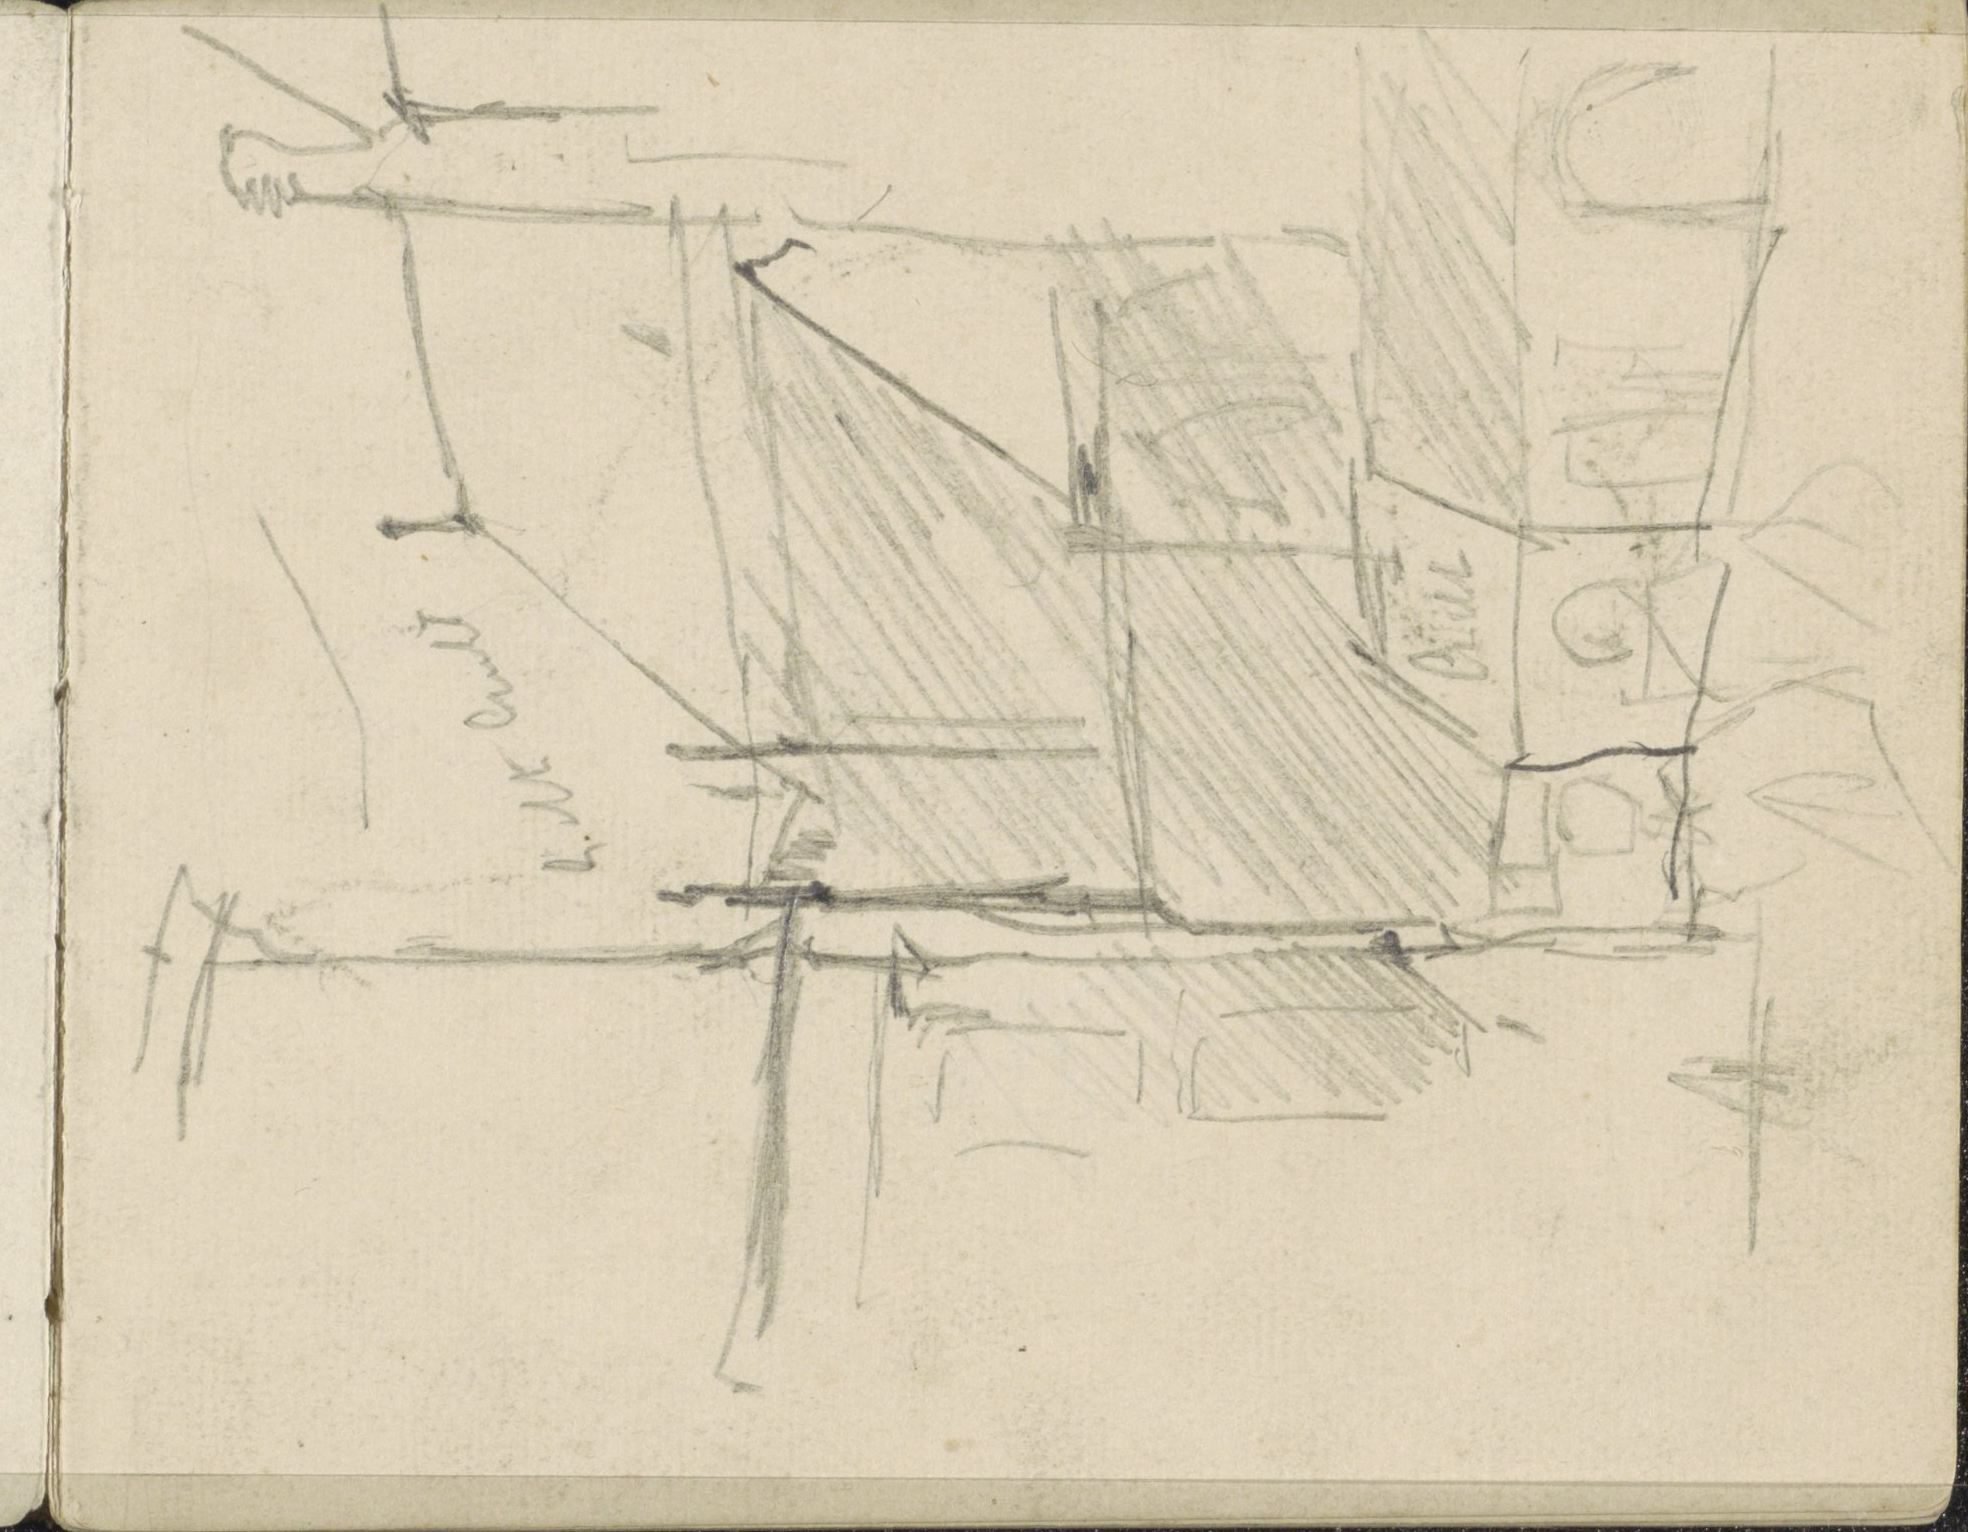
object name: sketchbook leaf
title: Gezicht op de Dam te Amsterdam met het Koninklijk Paleis en de Nieuwe Kerk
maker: george hendrik breitner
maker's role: draughtsman, painter, print maker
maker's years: 1857-1923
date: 1885-1898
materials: paper, pencil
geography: amsterdam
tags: church (exterior), square, place, circus, etc. (+ city(-scape) with figures, staffage), royal palace of amsterdam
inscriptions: kleurnotitie, handgeschreven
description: Pagina 8 uit een schetsboek met 32 bladen.